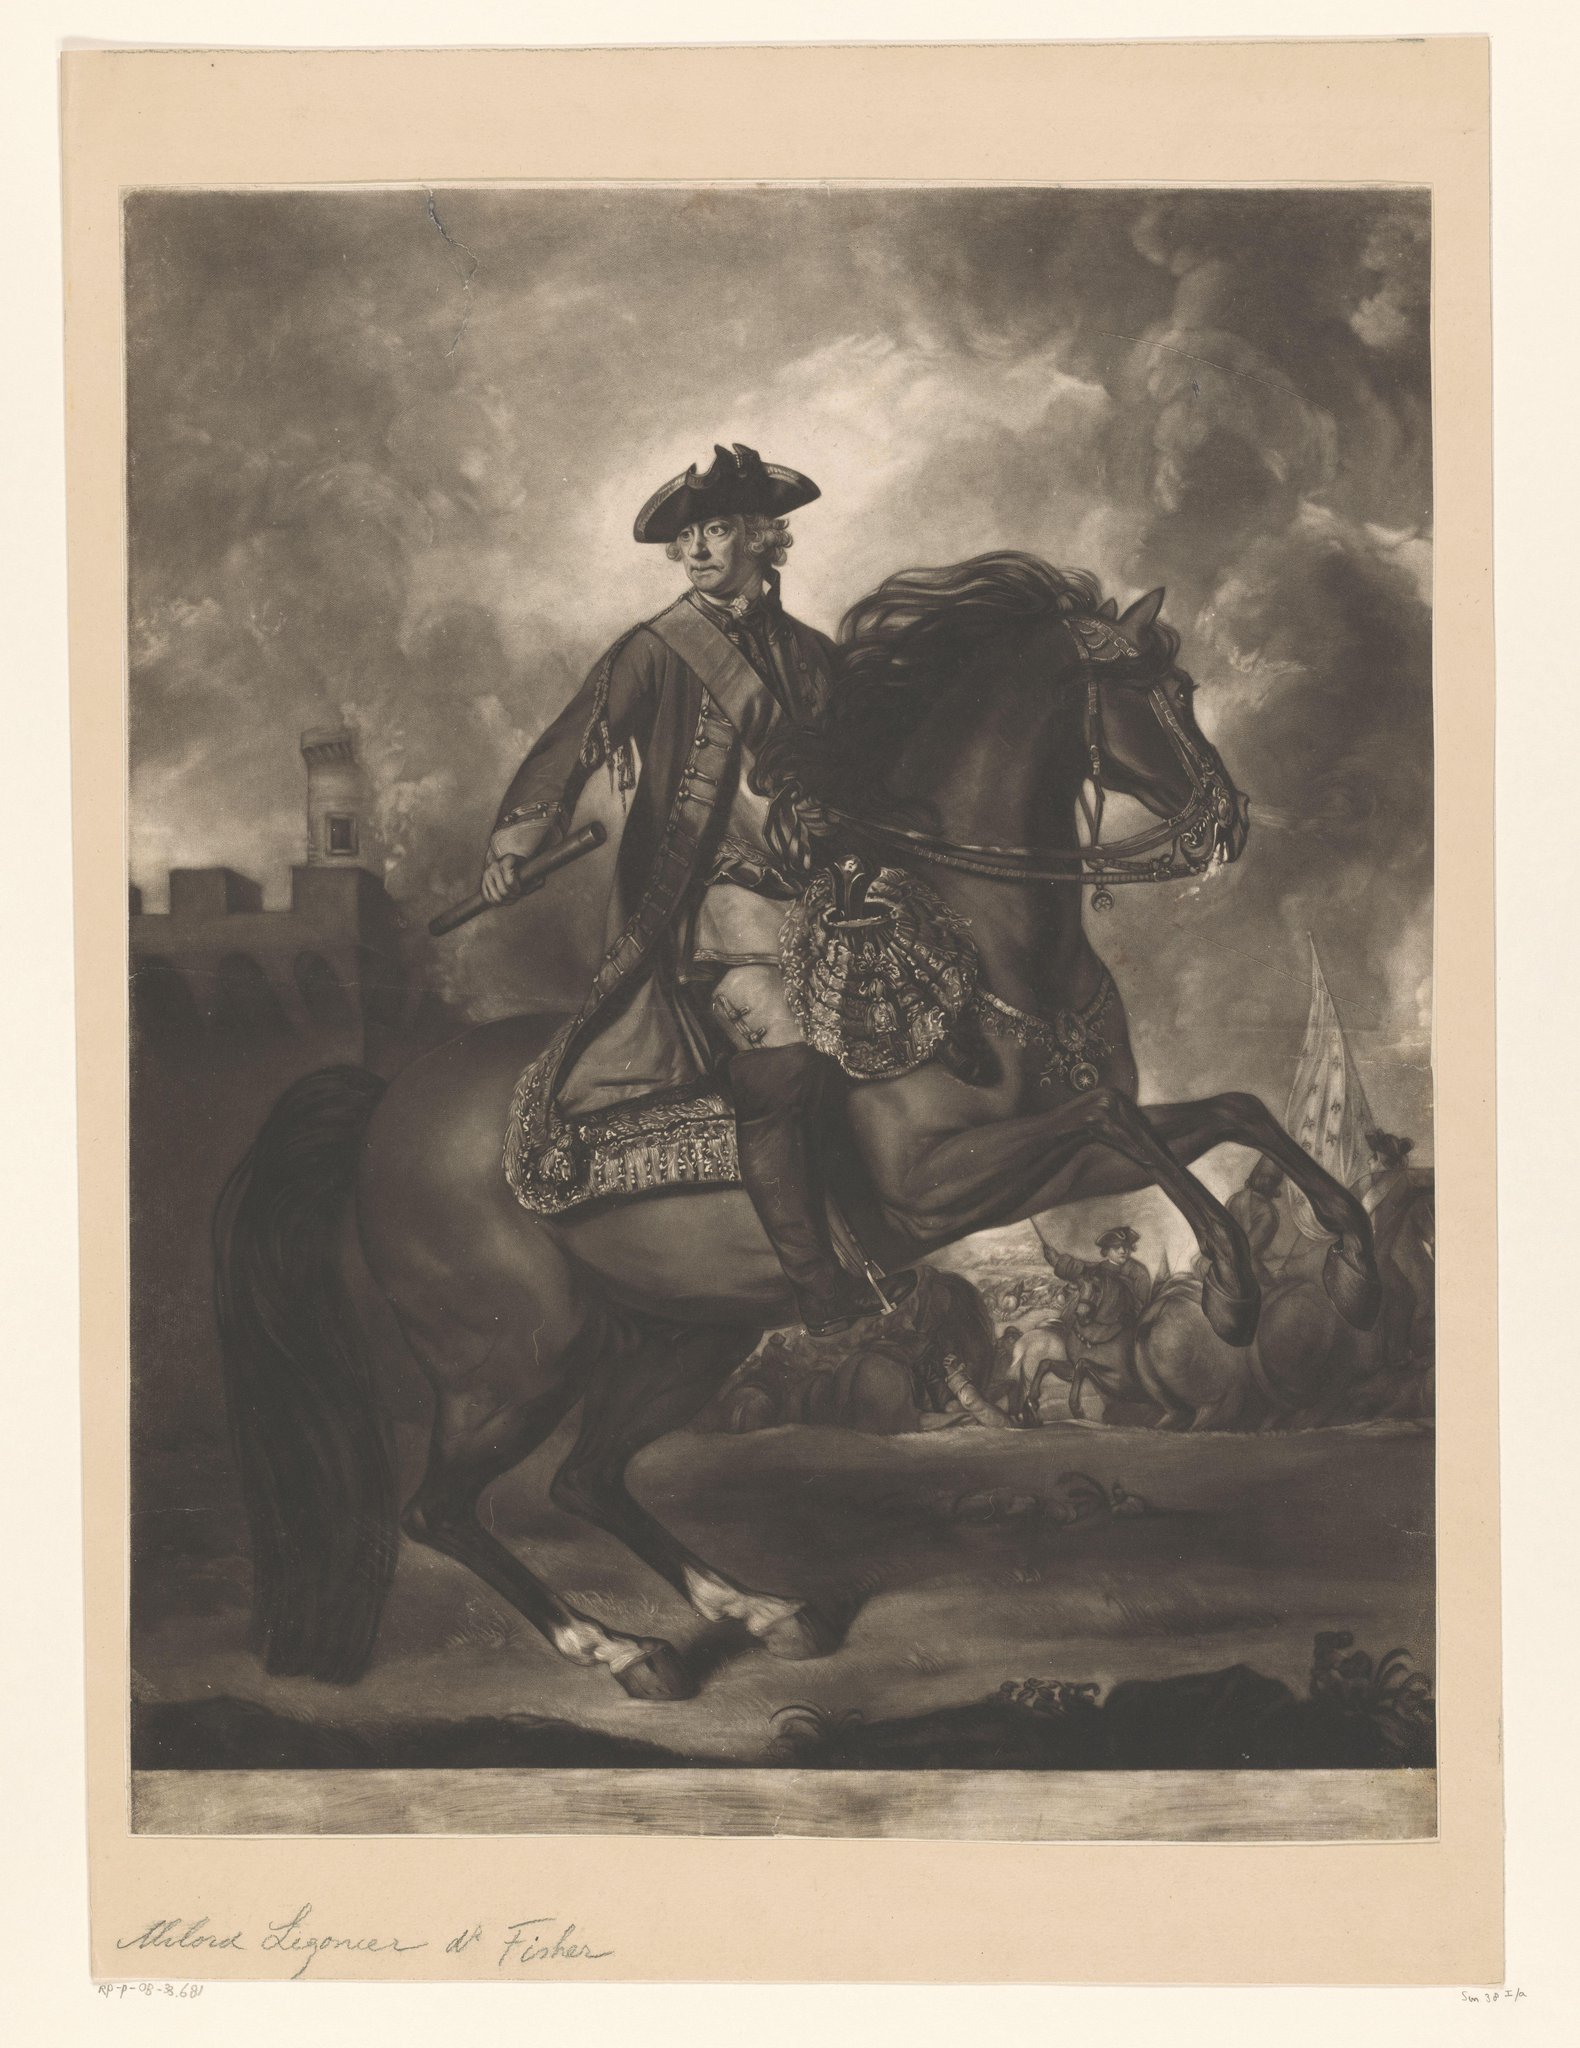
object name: print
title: Ruiterportret van John Ligonier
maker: edward fisher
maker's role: print maker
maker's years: 1722-1785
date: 1760-1800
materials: paper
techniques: mezzotint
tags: equestrian state-portrait, historical persons, officer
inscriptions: collector's mark: Lugt 240